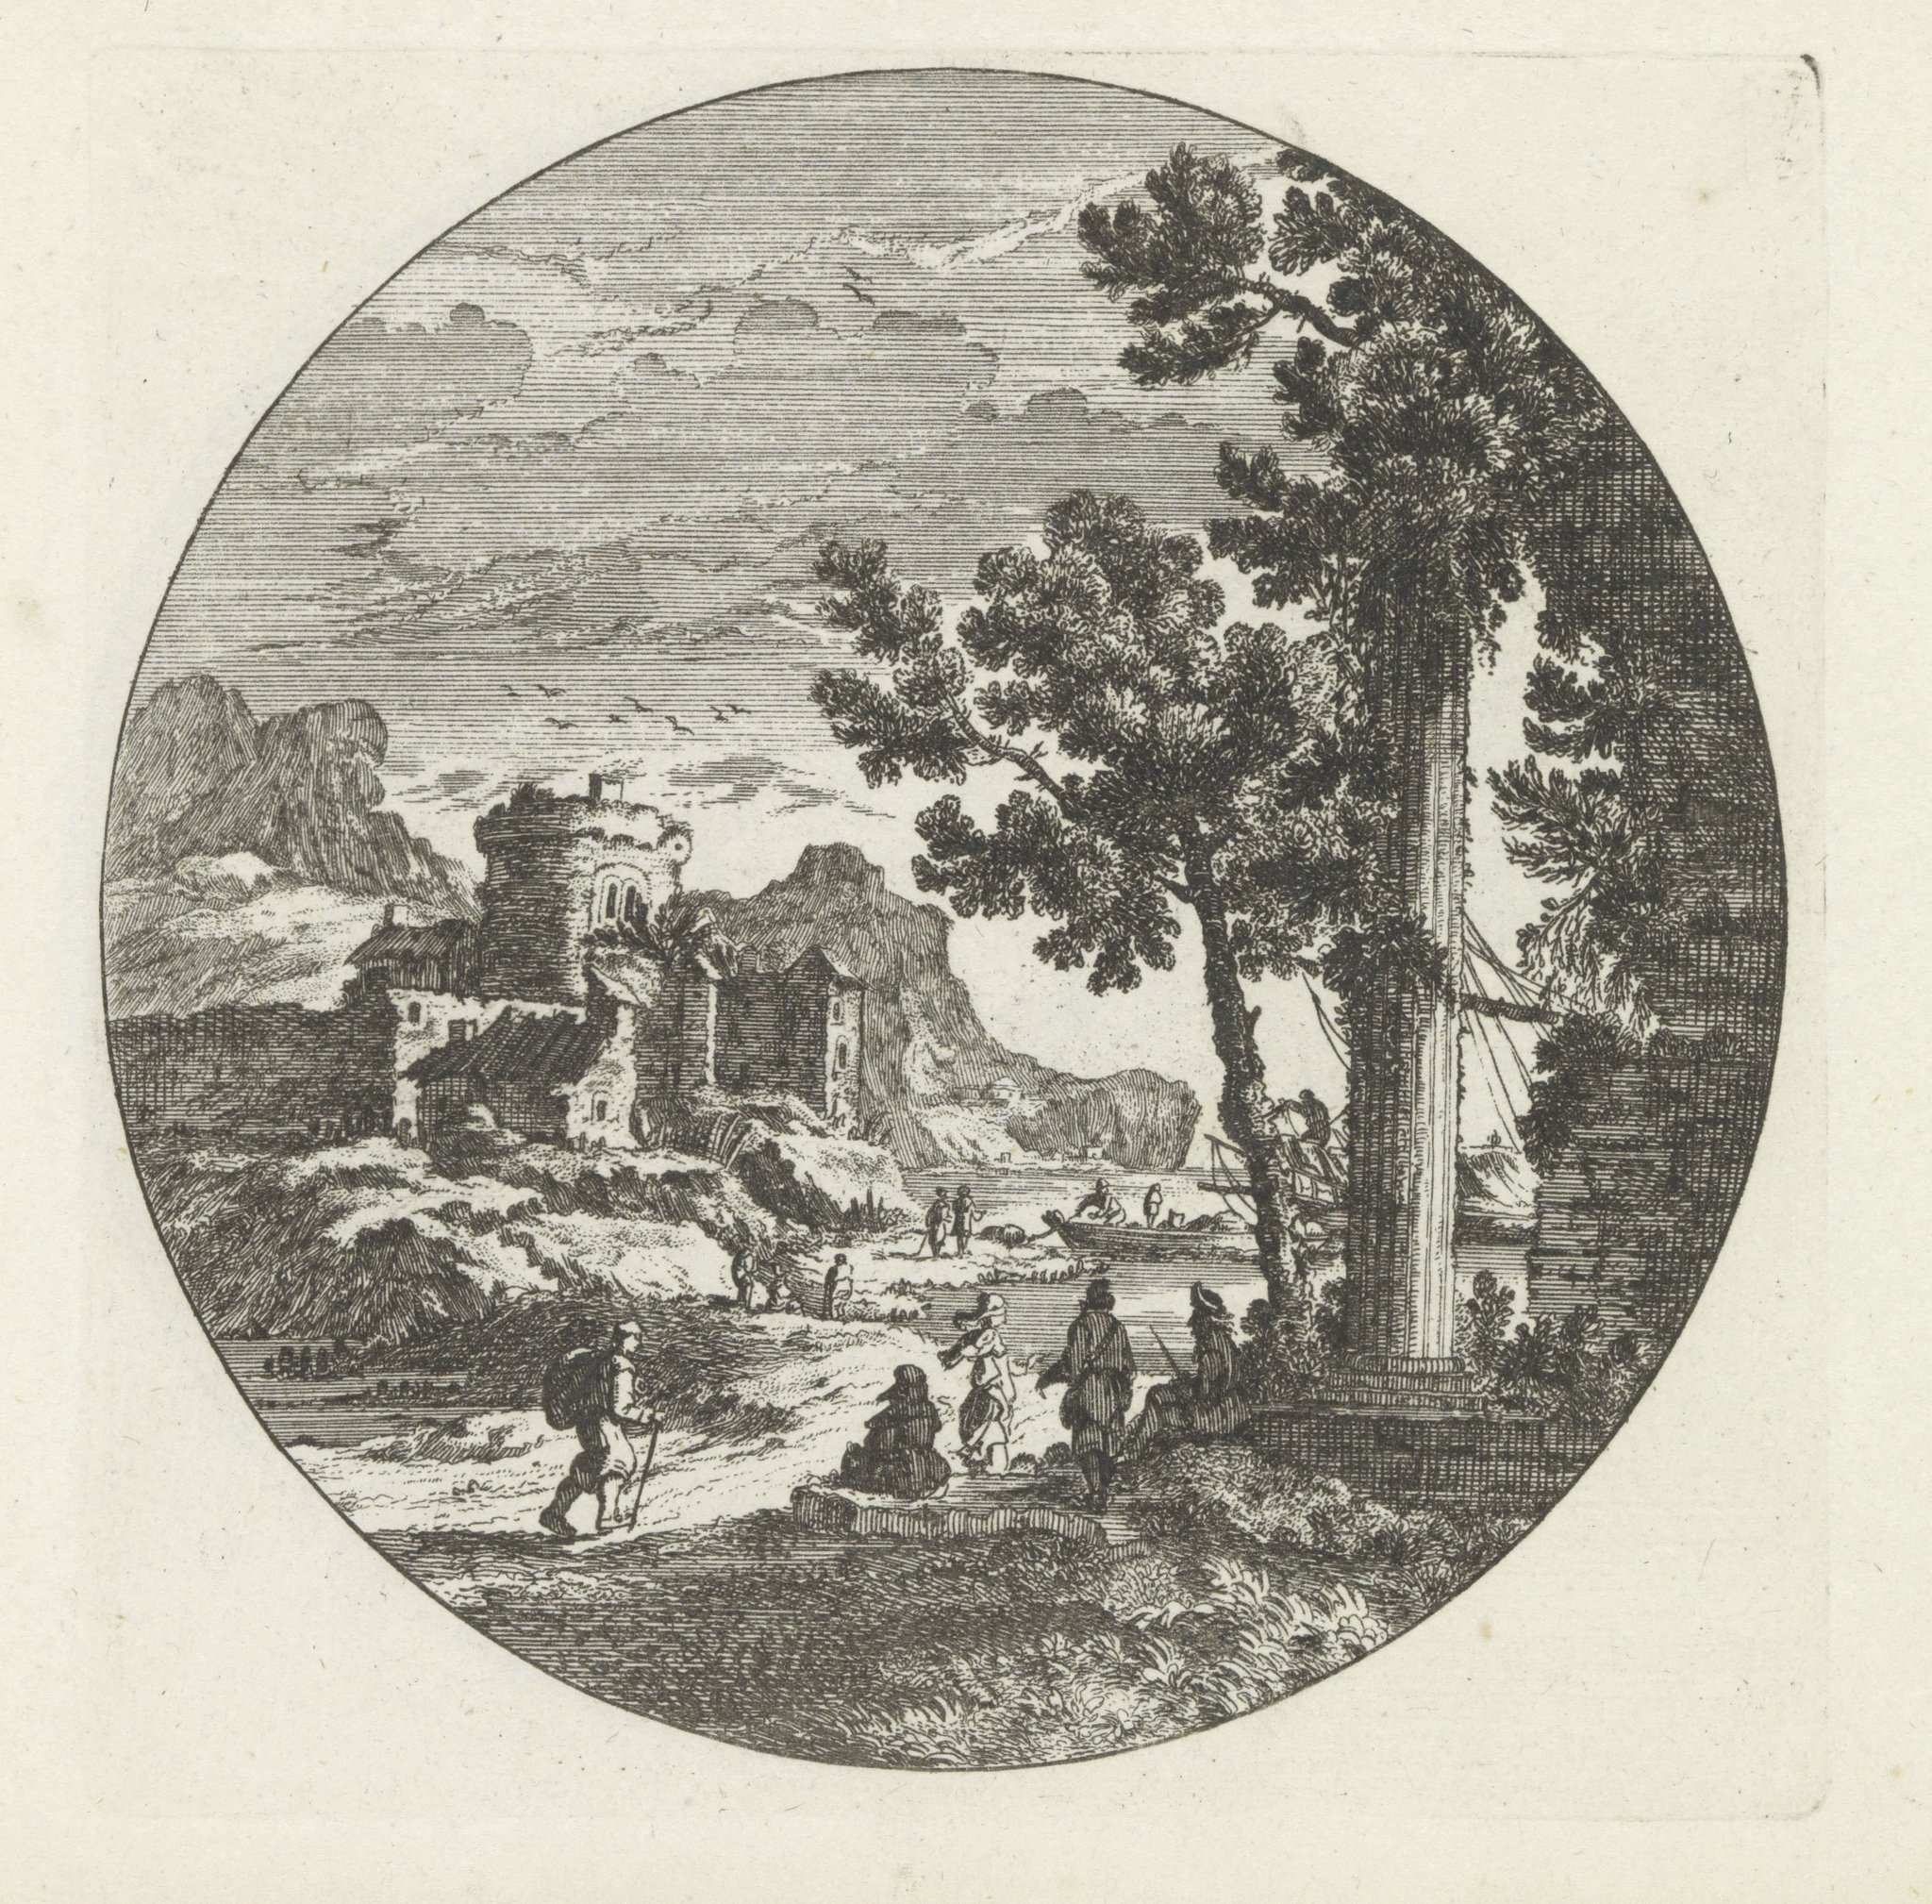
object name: album leaf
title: Spiegel der natuur en school der teekenkunde (...)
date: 1614-1656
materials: paper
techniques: etching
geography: amsterdam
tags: landscapes, column, pillar ~ architecture, road, path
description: Landschap met figuren bij een haven aan een rotsachtige kust. Rechts een zuil. De prent maakt deel uit van een album.